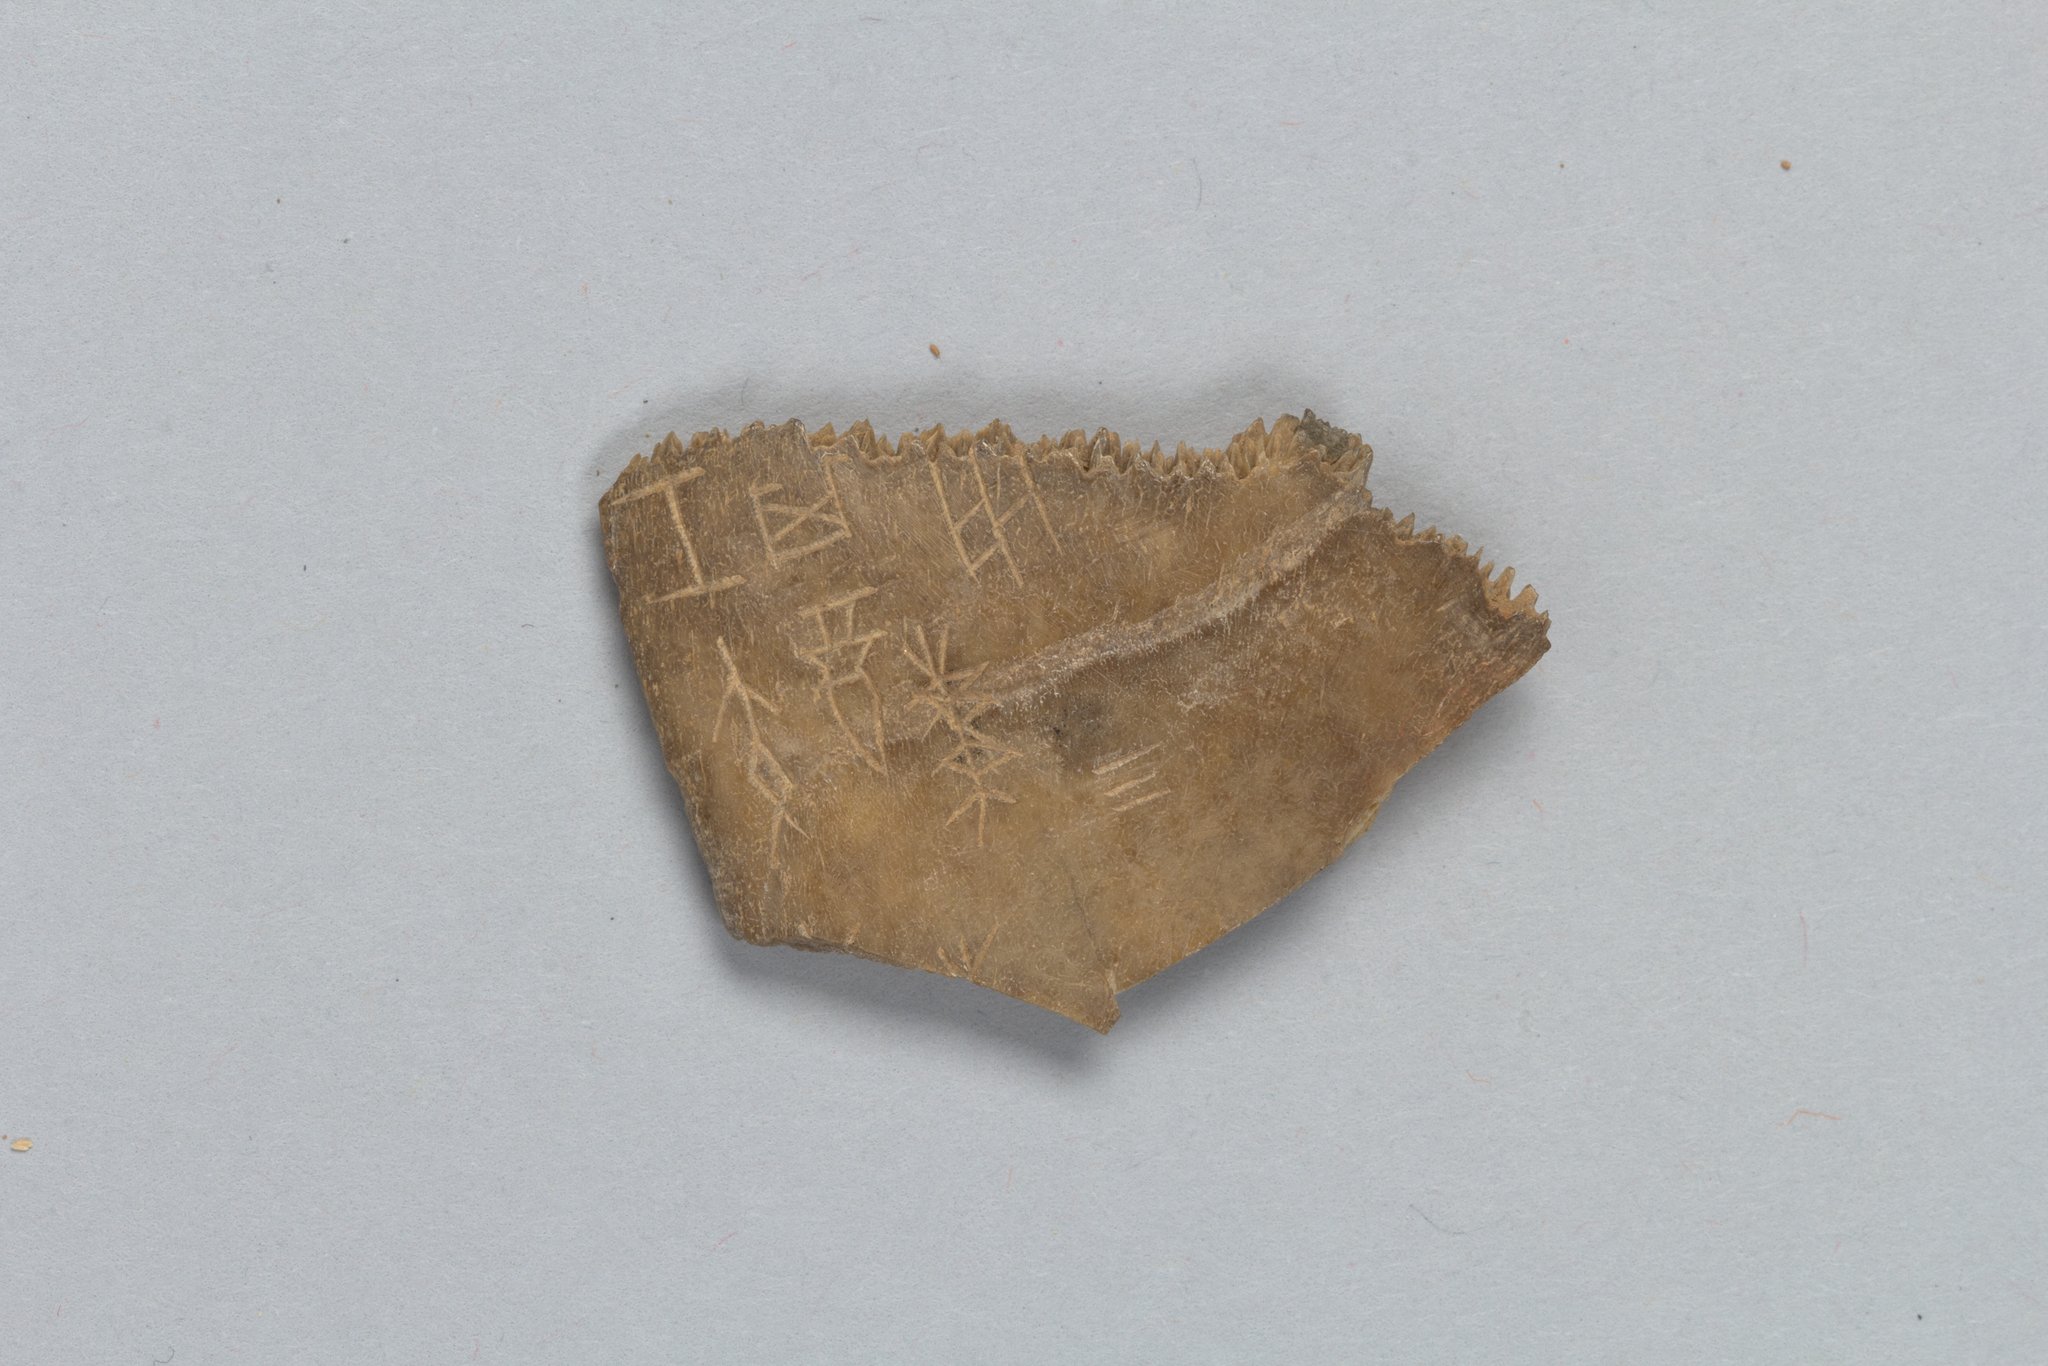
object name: oracle bone fragment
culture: chinese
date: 1600-1046 BCE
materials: bone